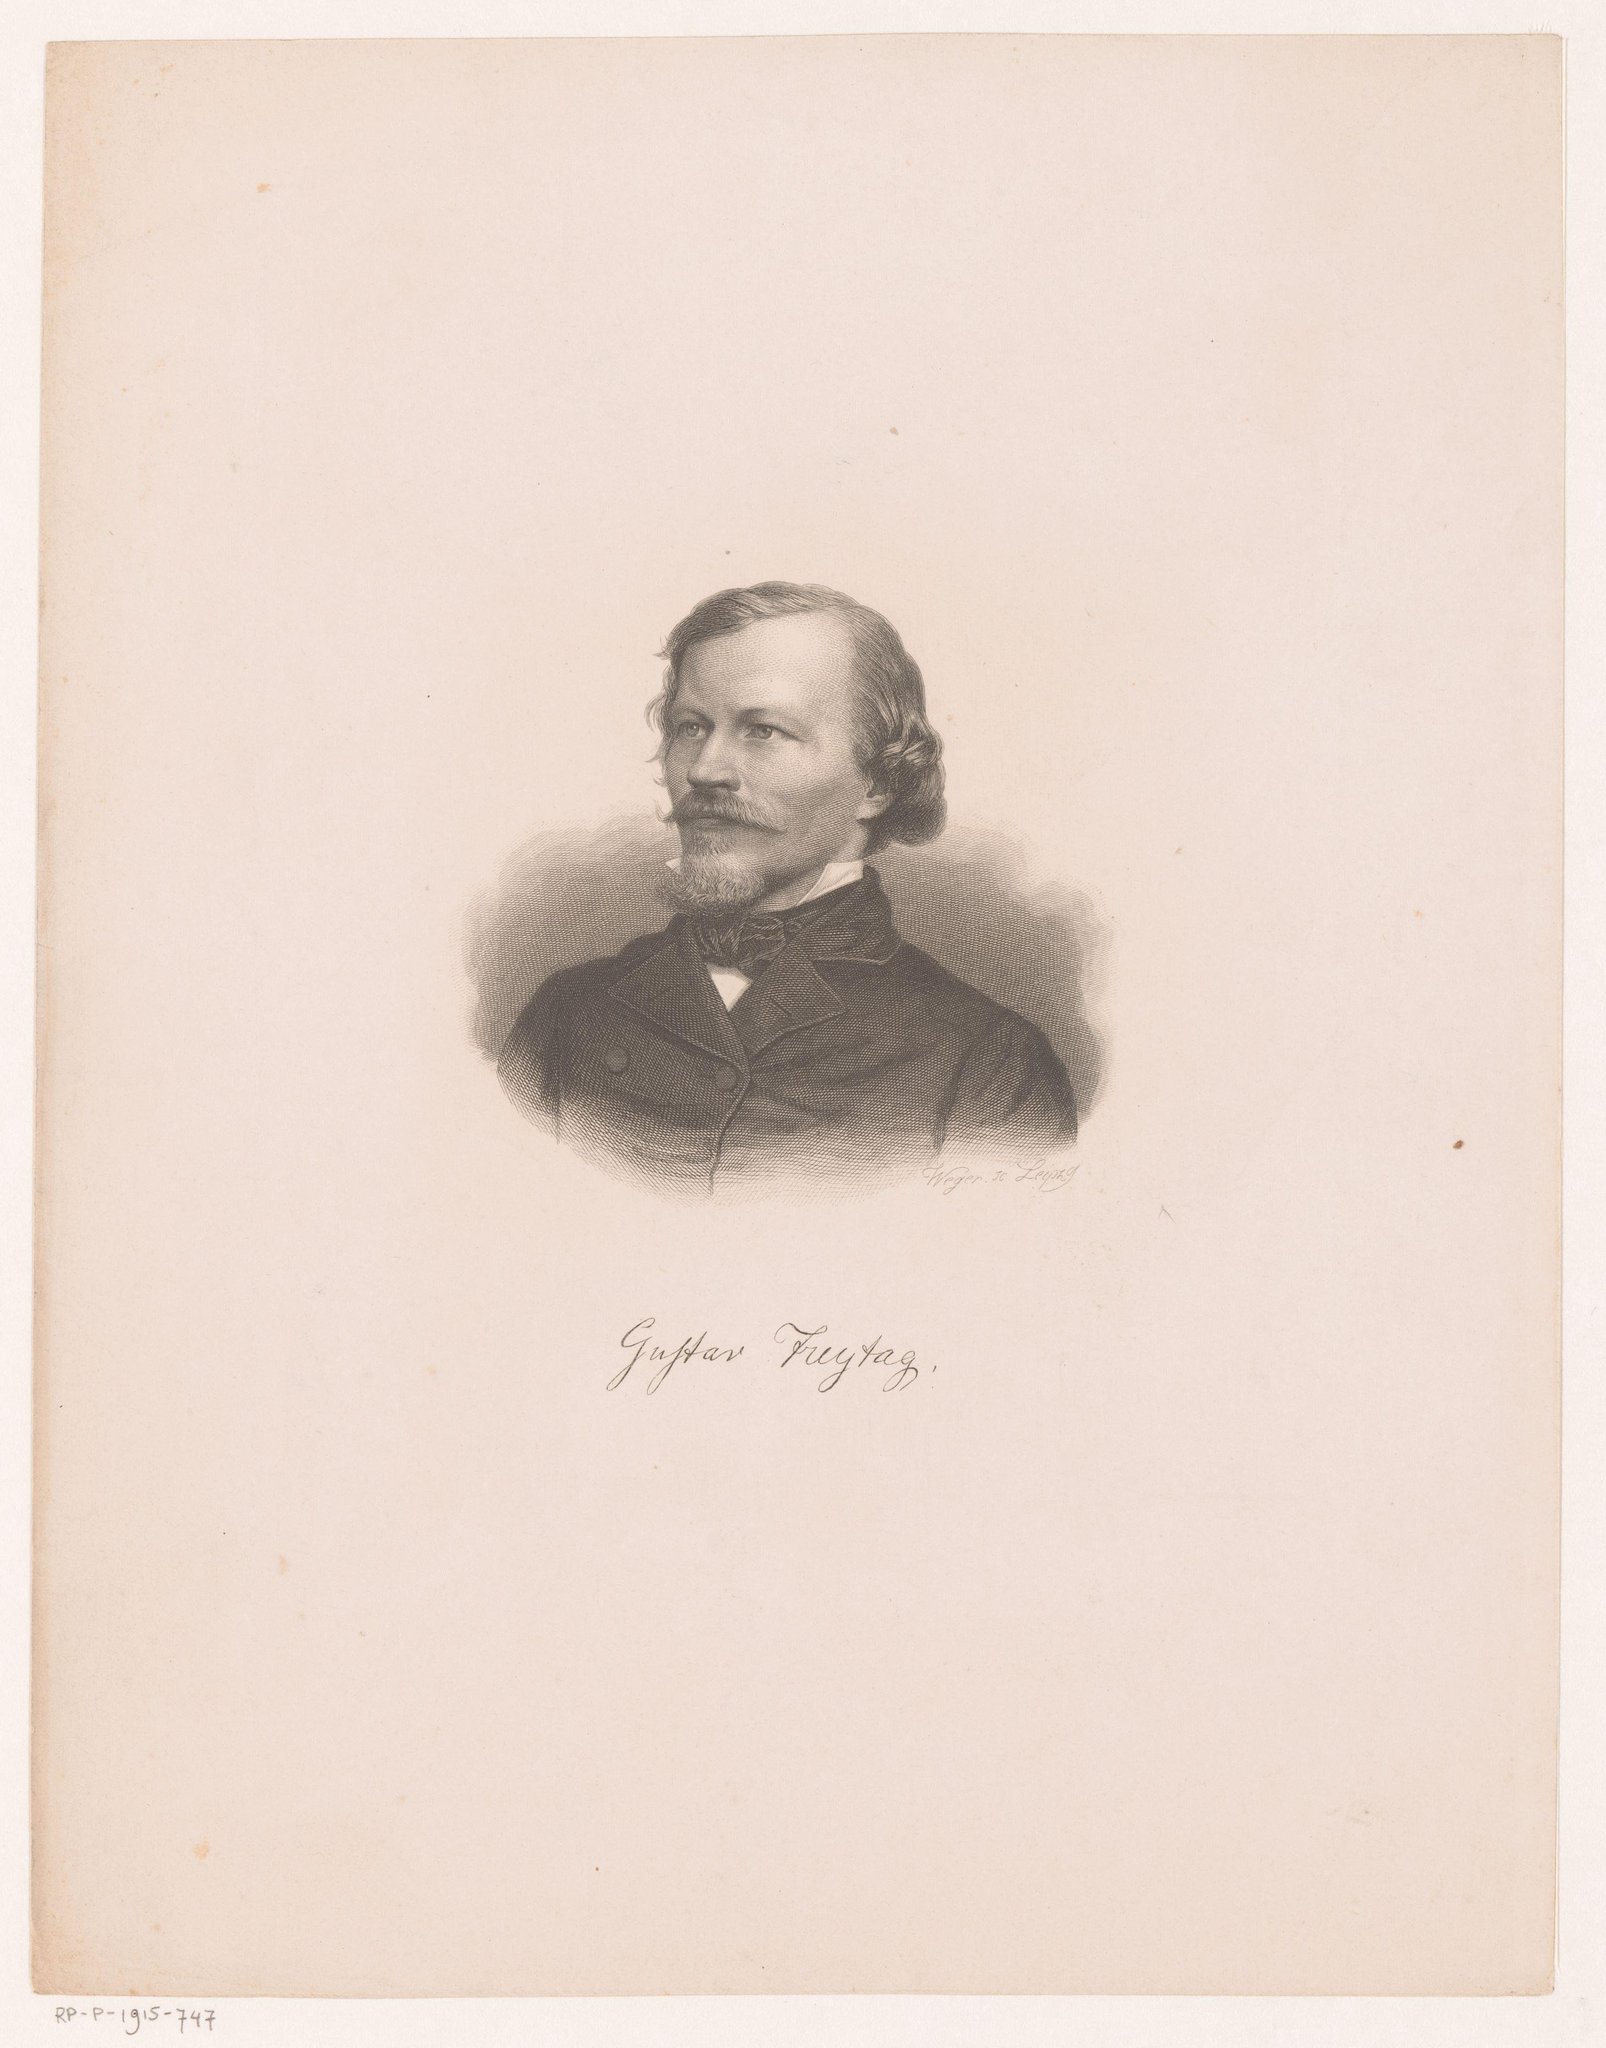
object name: print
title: Portret van Gustav Freytag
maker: august weger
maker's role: print maker, printer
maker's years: 1823-1892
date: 1849-1892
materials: paper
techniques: engraving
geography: leipzig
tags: historical persons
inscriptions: collector's mark: Lugt 2228